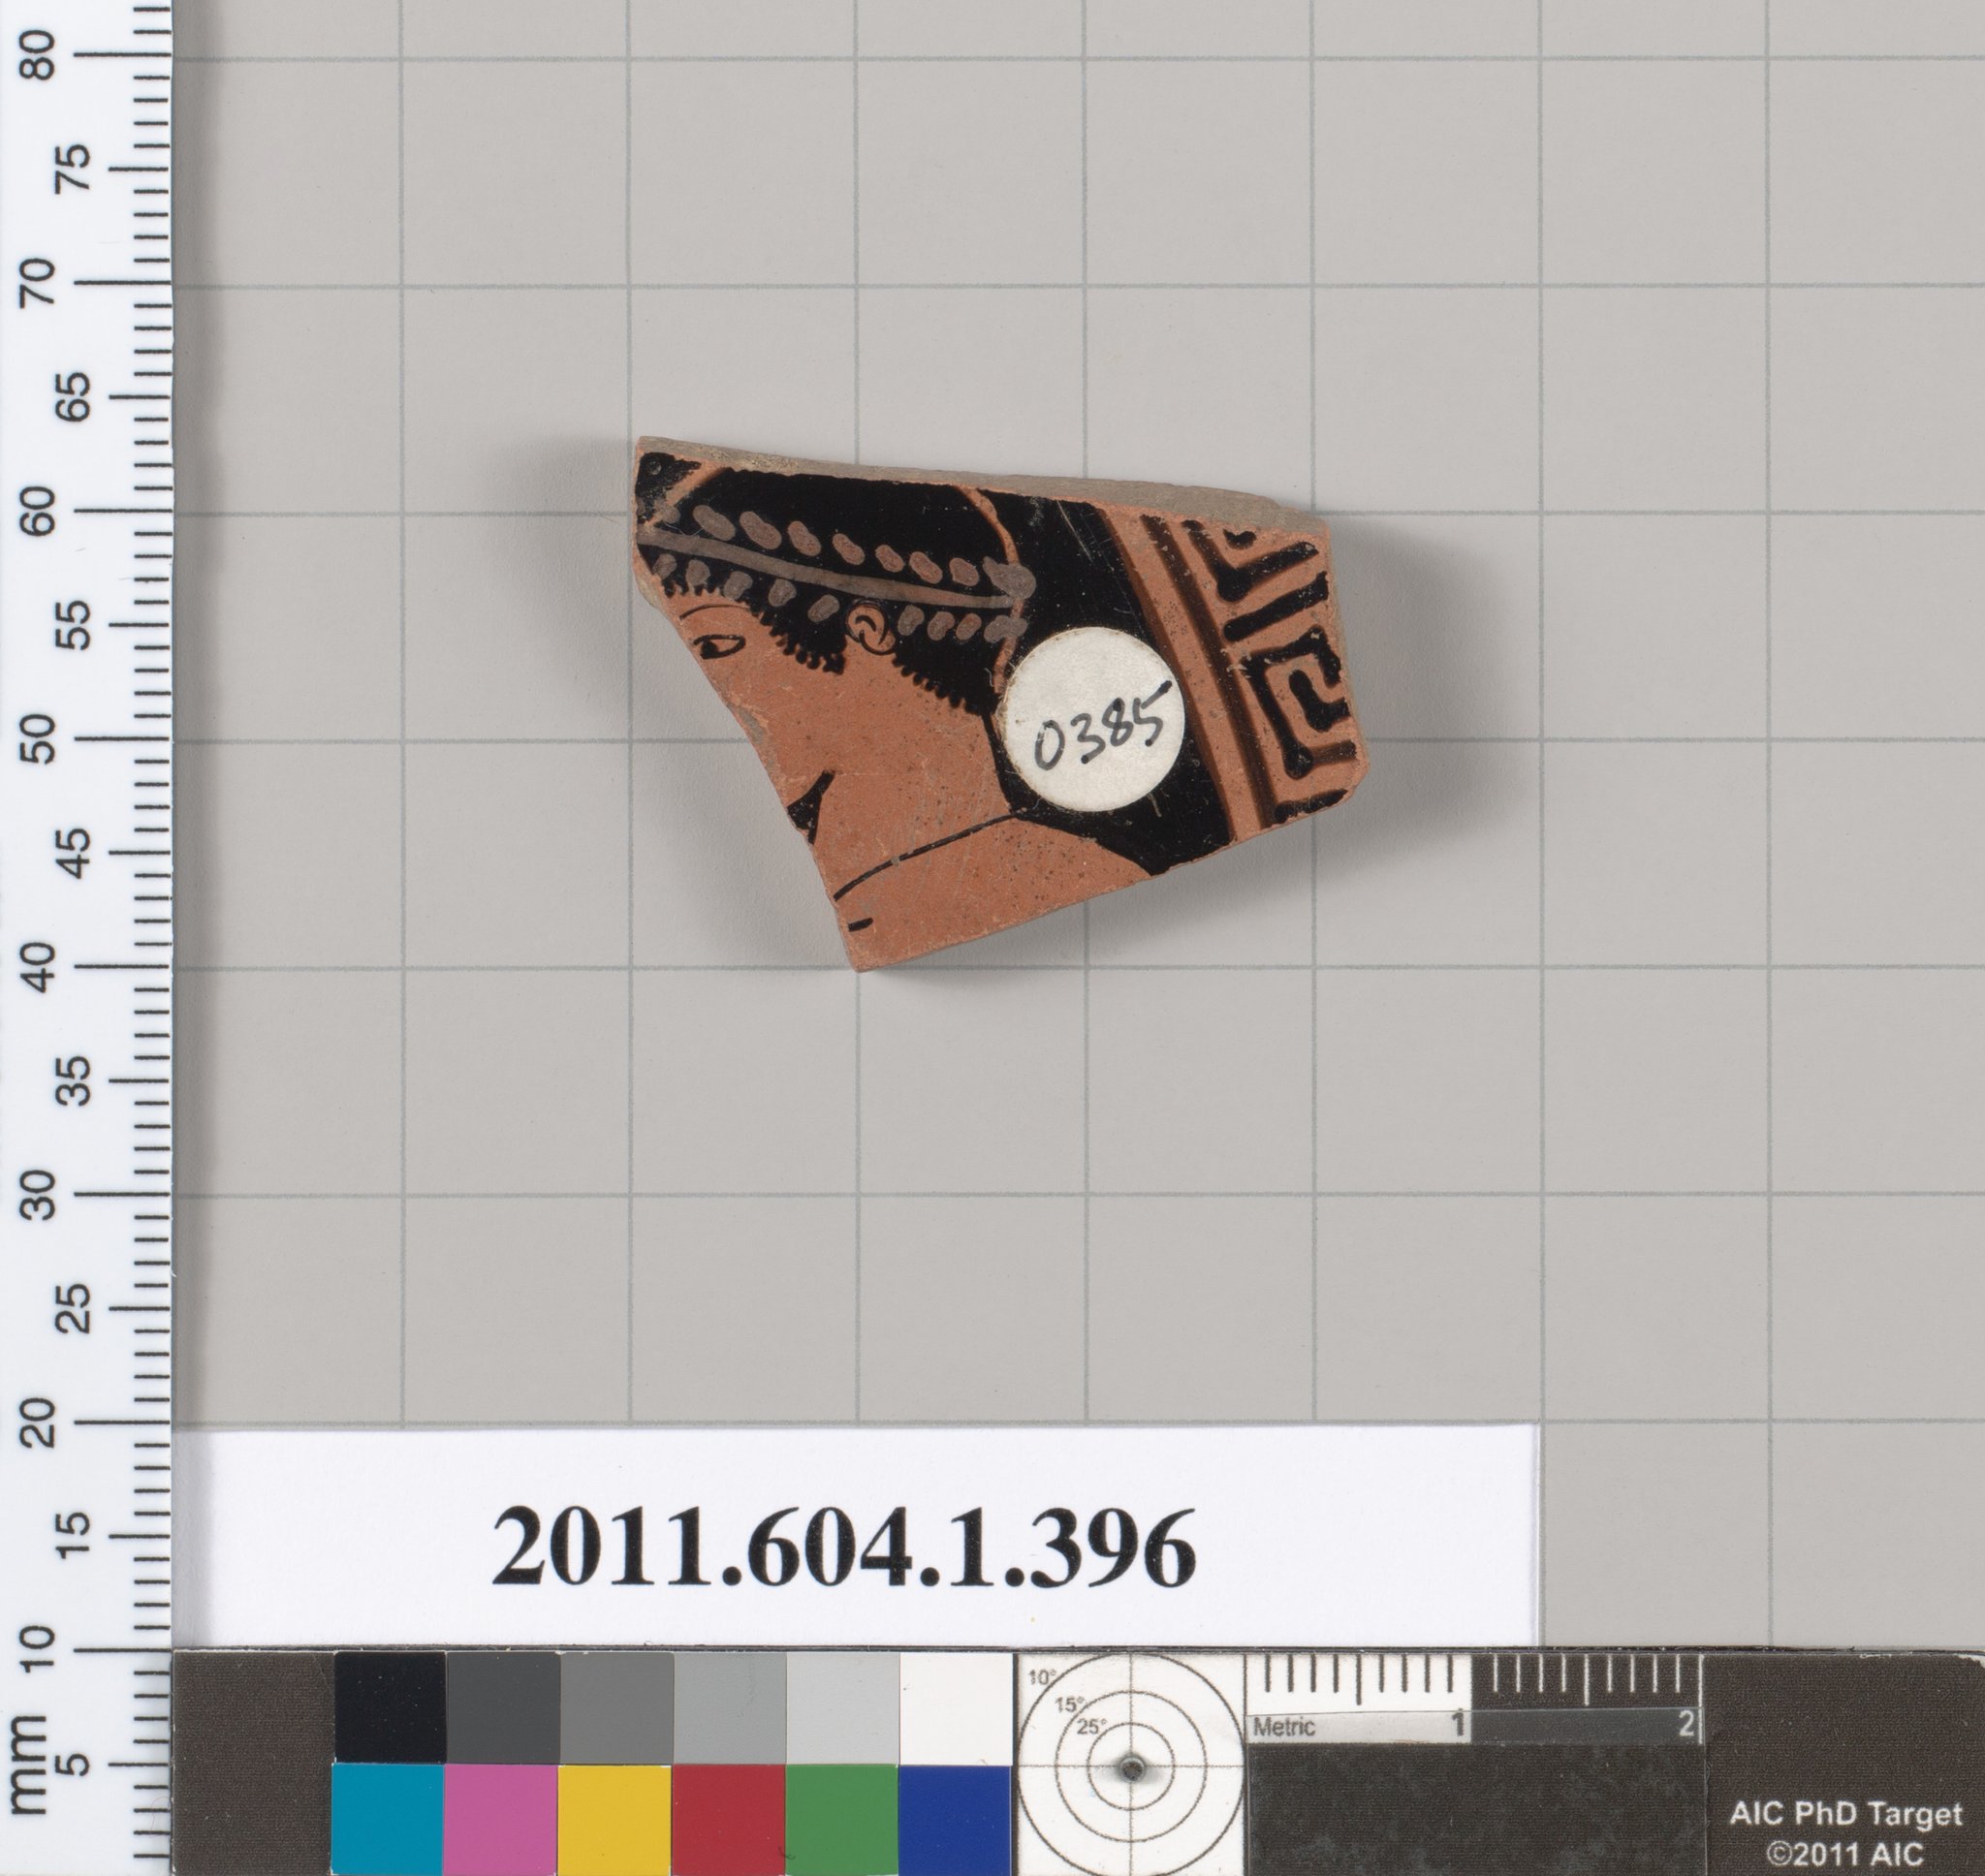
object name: kylix fragment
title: Terracotta fragment of a kylix (drinking cup)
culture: greek, attic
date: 490-480 BCE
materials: terracotta